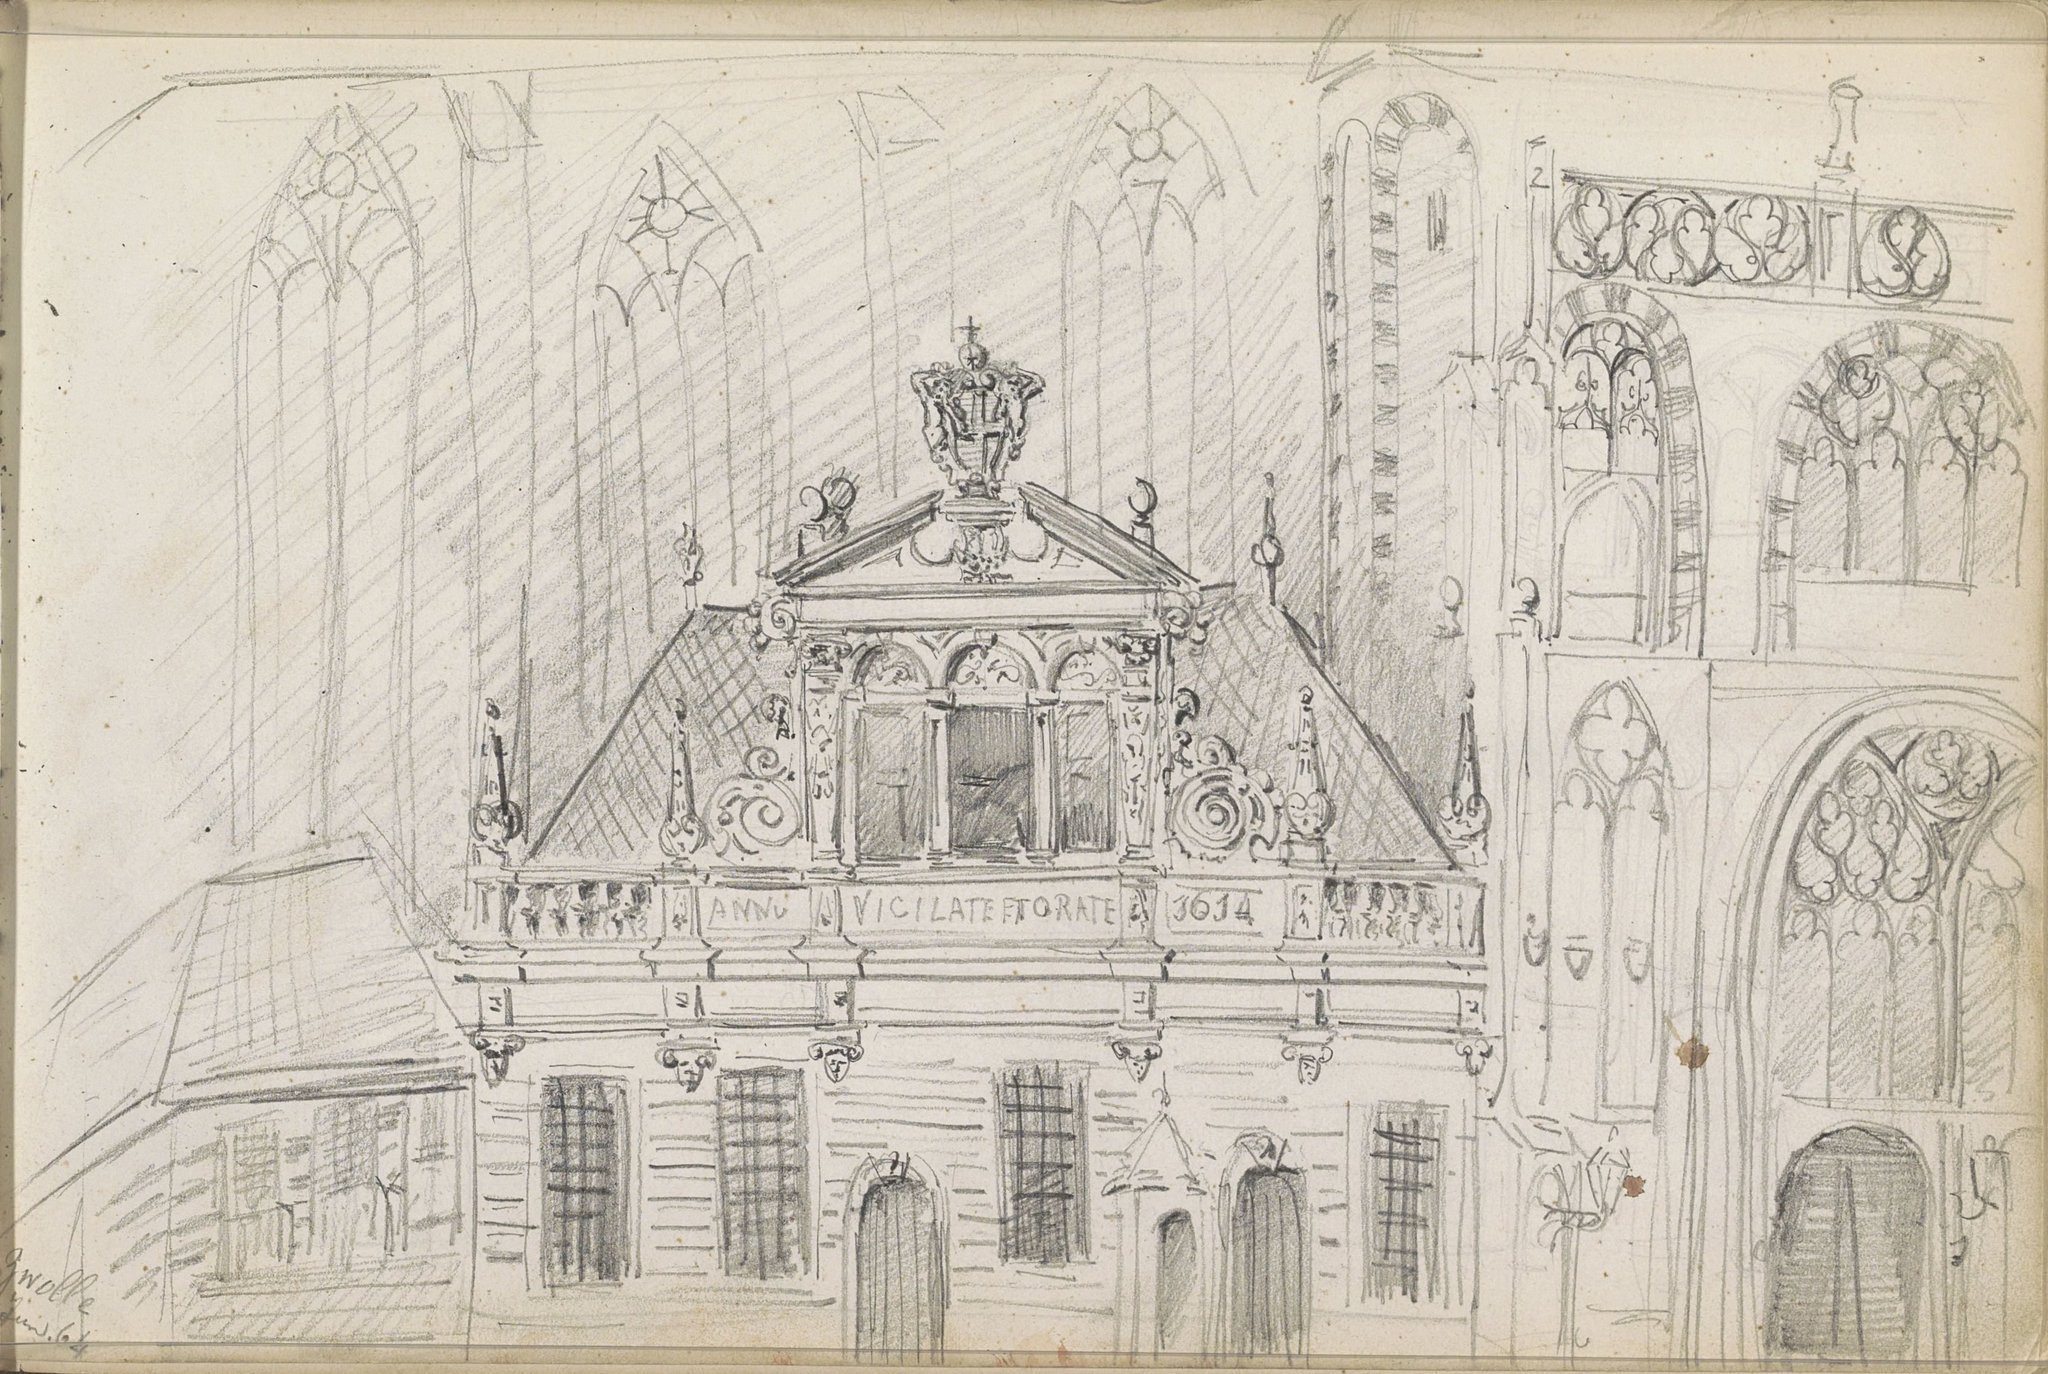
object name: sketchbook leaf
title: Sint-Michaëlskerk te Zwolle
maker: isaac gosschalk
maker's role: draughtsman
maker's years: 1838-1907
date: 1806-1864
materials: paper, pencil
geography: zwolle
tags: church (exterior)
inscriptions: date and inscription: ‘Zwolle/ Jun. 64’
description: Blad 27 recto uit een schetsboek met 58 bladen.